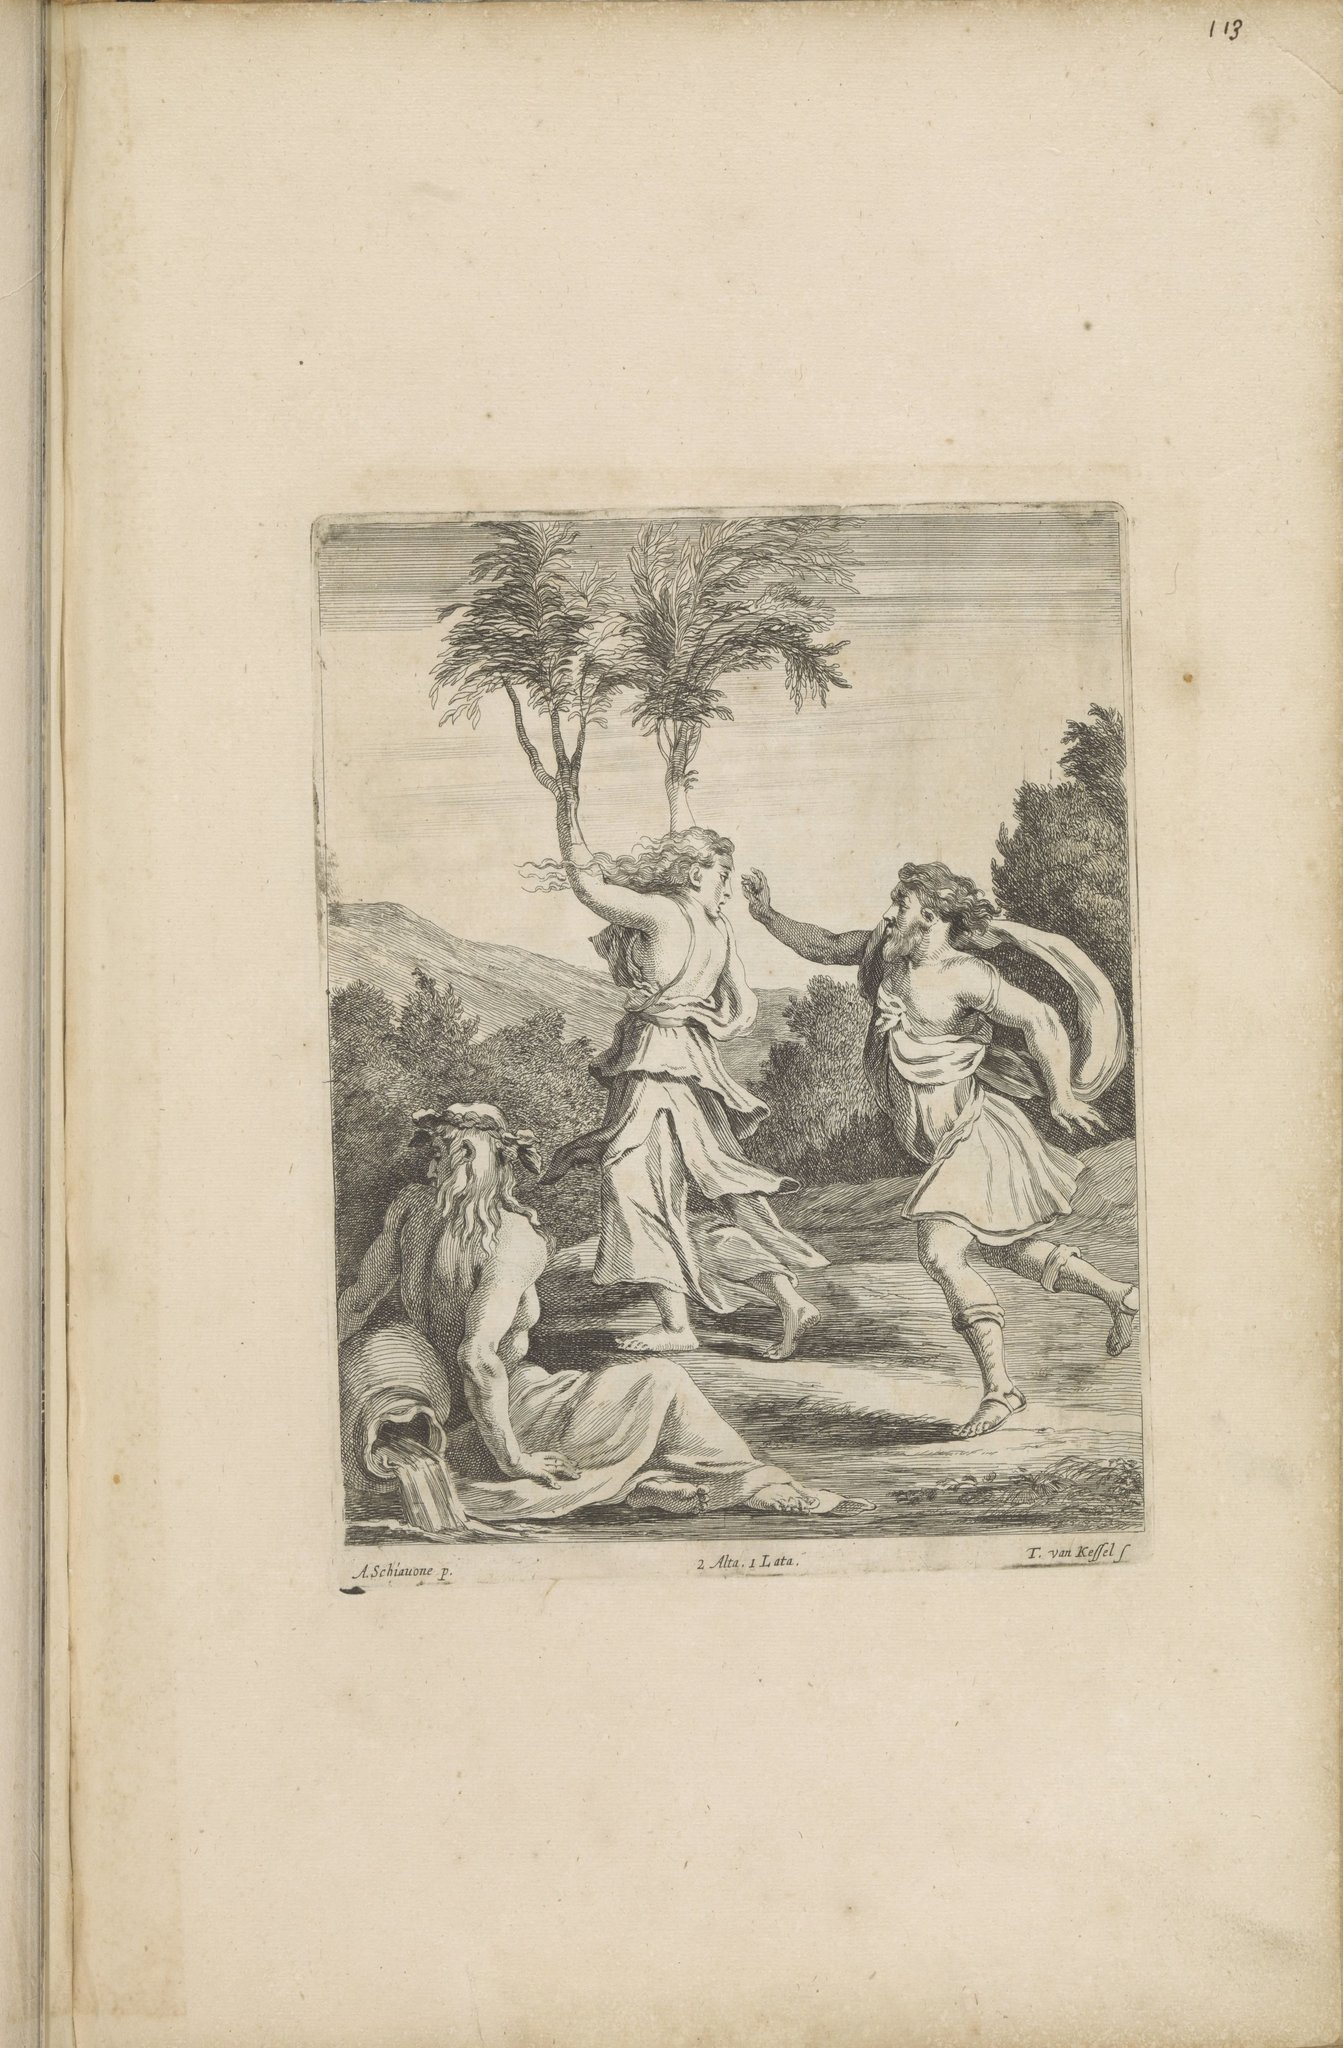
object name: album leaf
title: Apollo en Daphne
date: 1660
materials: paper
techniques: etching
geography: italy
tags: daphne changed into a laurel-tree: while fleeing from apollo, daphne is changed into a laurel-tree by her father peneus (ovid, metamorphoses i 548)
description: De prent is vervaardigd naar het schilderij van Schiavone dat zich in de collectie van het Kunsthistorisches Museum te Wenen bevindt (inventarisnummer GG_356). David Teniers heeft waarschijnlijk van alle schilderijen uit de collectie van Leopold Willem van Oostenrijk een olieverfstudie op doek of paneel vervaardigd (zgn. pasticcio), die als voorbeeld voor de prentmakers diende. Het is niet altijd duidelijk of de pasticci door hem zijn gemaakt of door zijn atelier. Niet alle pasticci zijn overgeleverd.